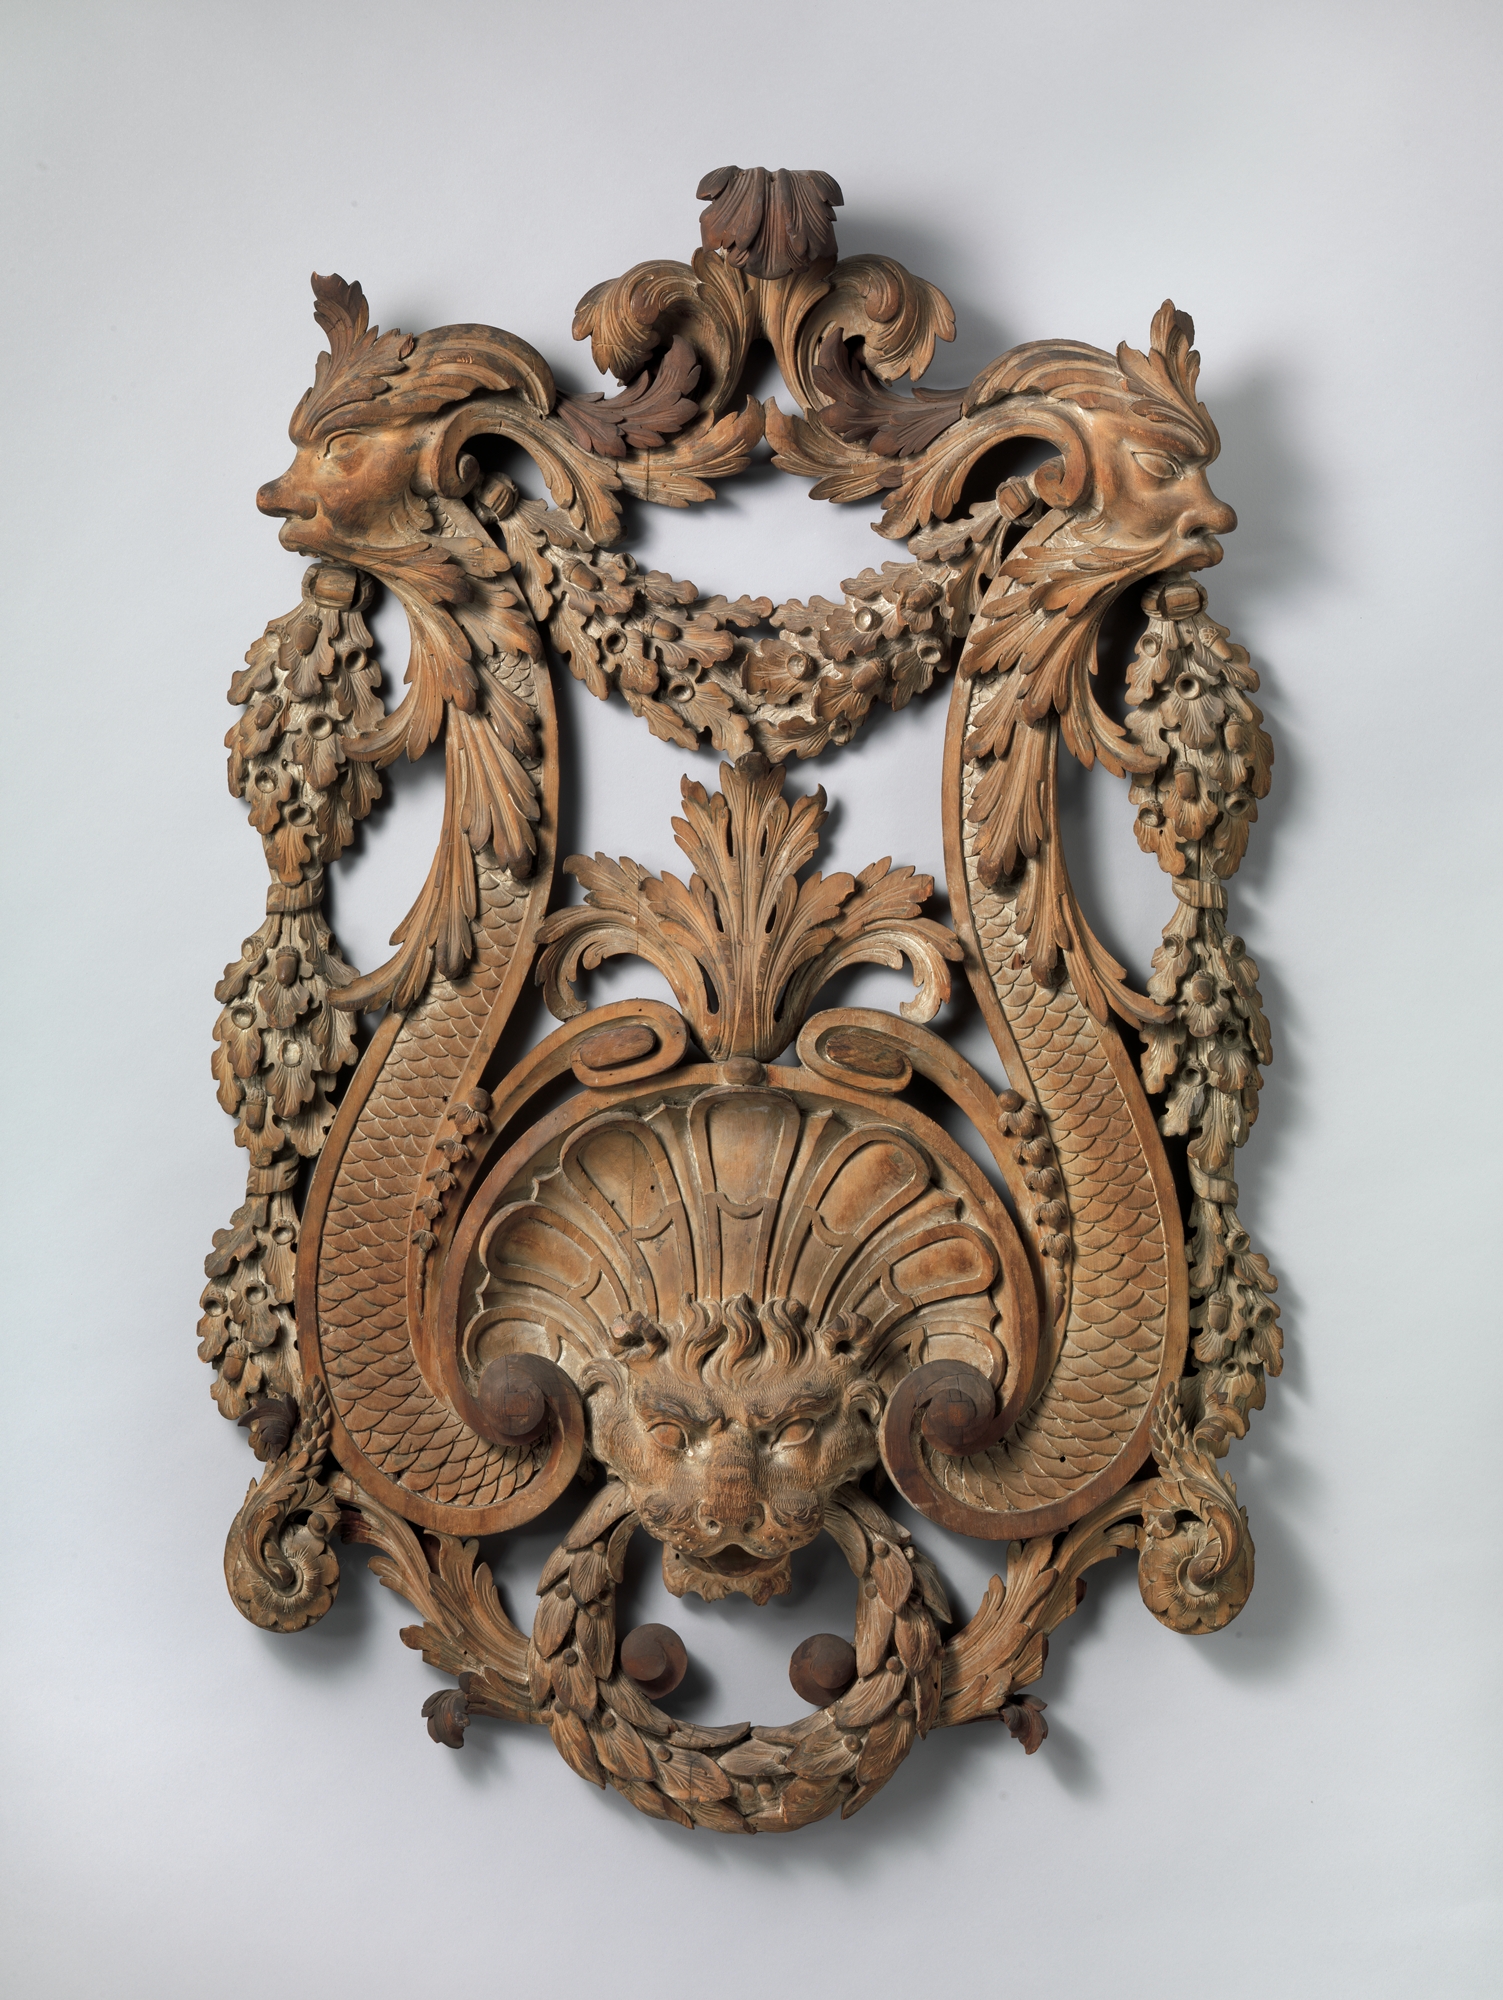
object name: wall light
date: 1730-1740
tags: garlands,lions